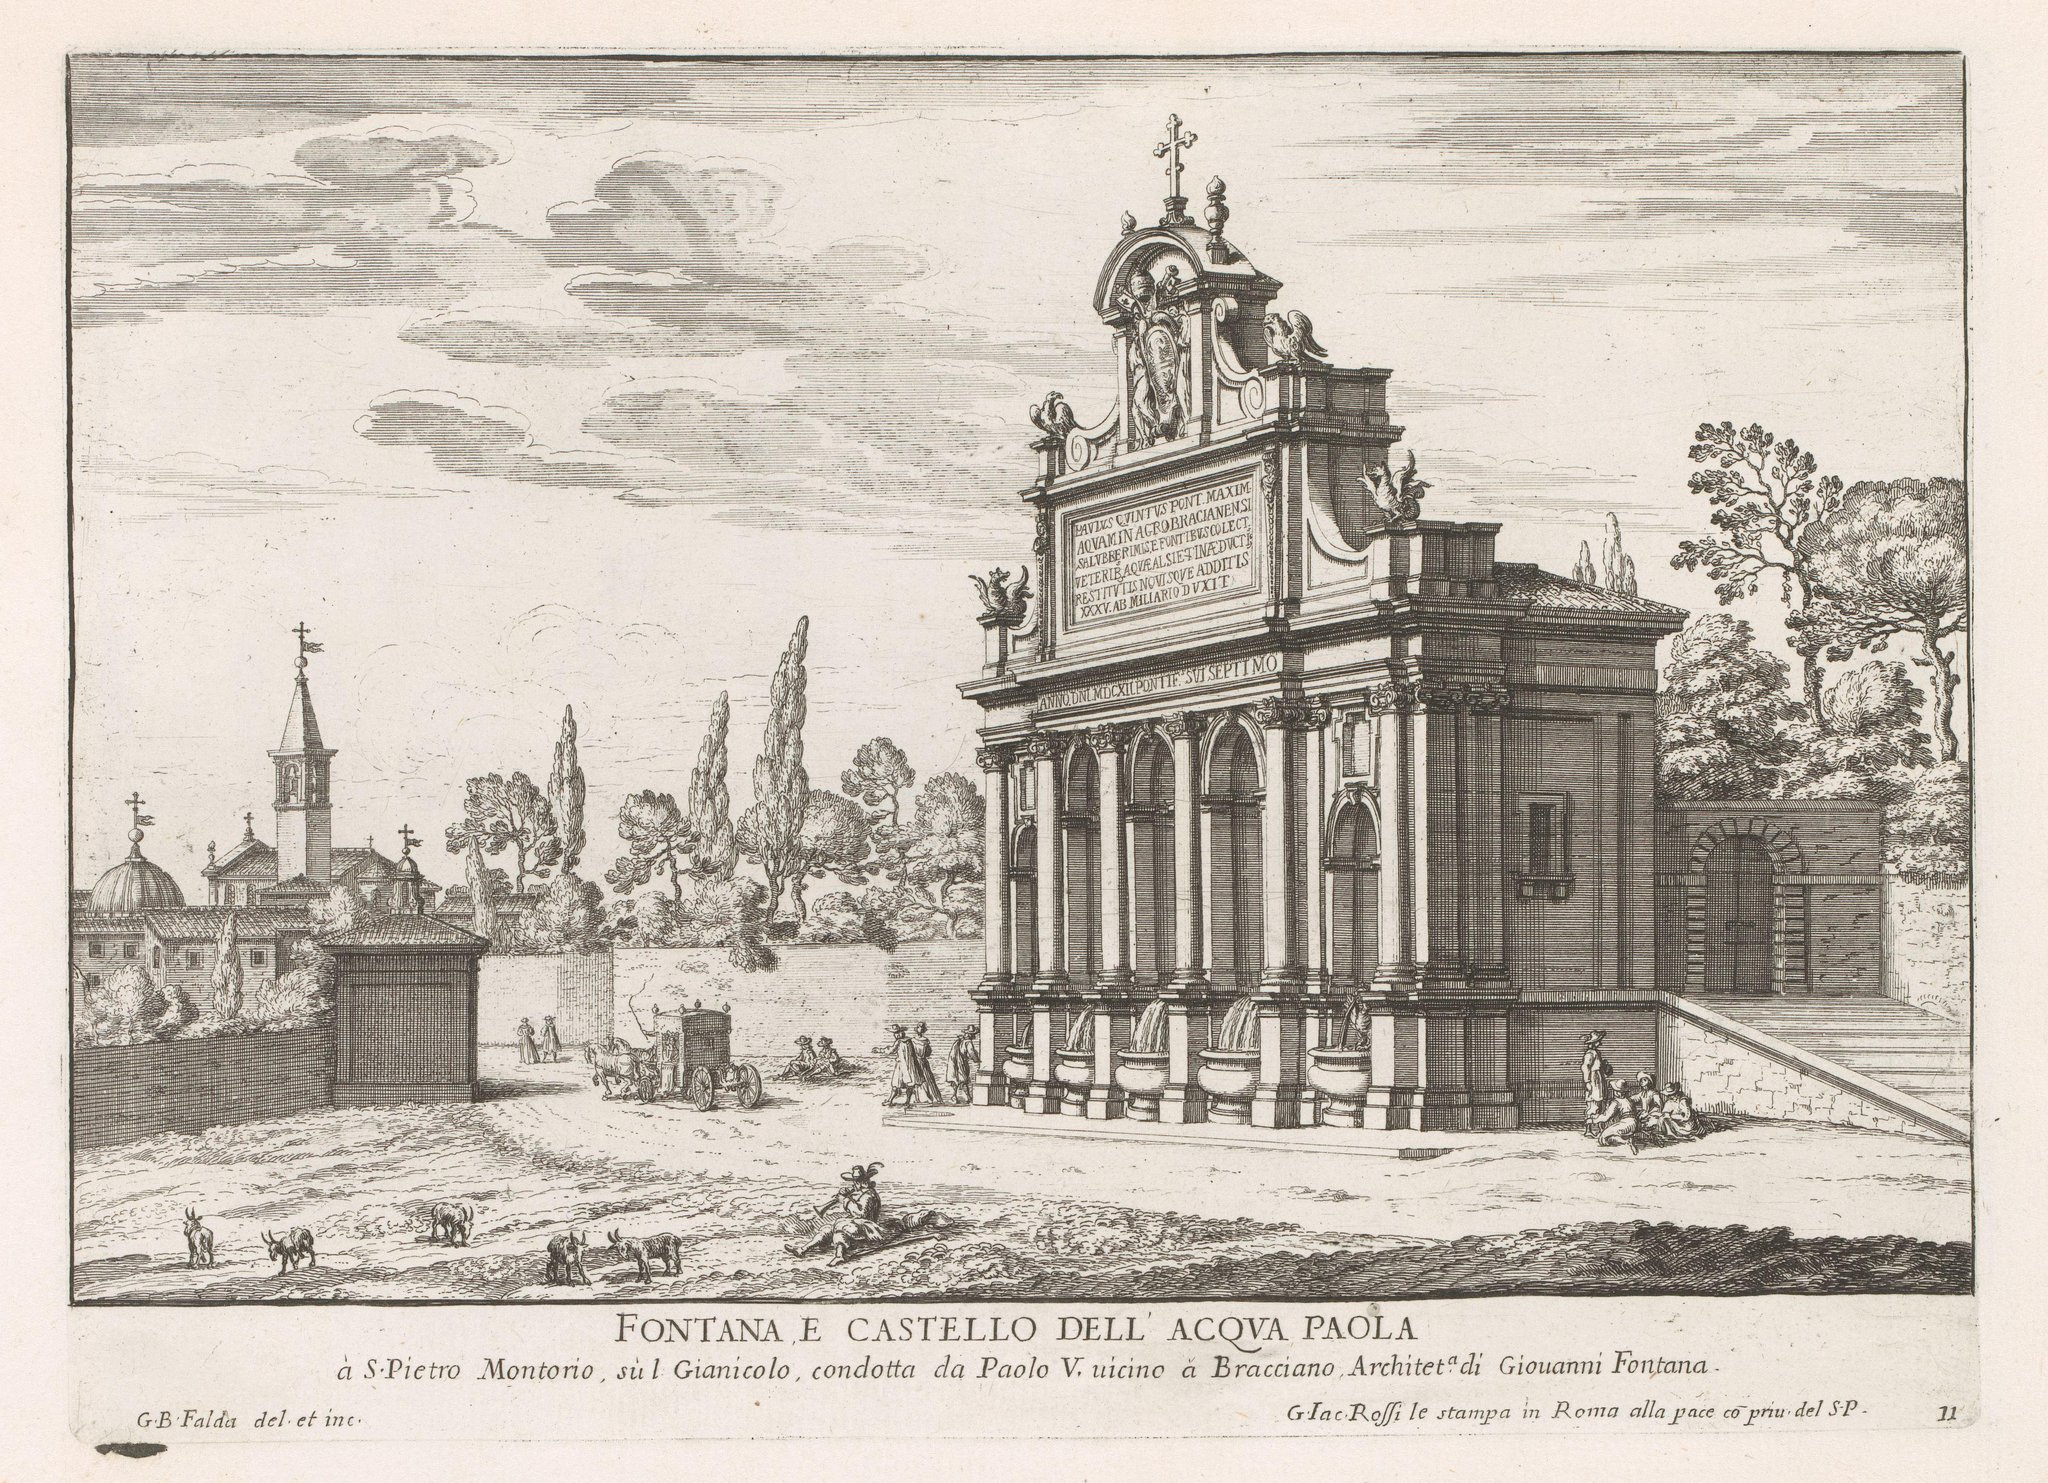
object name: album leaf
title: Fontane di Roma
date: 1653-1691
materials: paper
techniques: etching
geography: vatican city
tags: ornamental fountain, rome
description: Genummerd rechtsonder: 11. De prent maakt deel uit van een album.